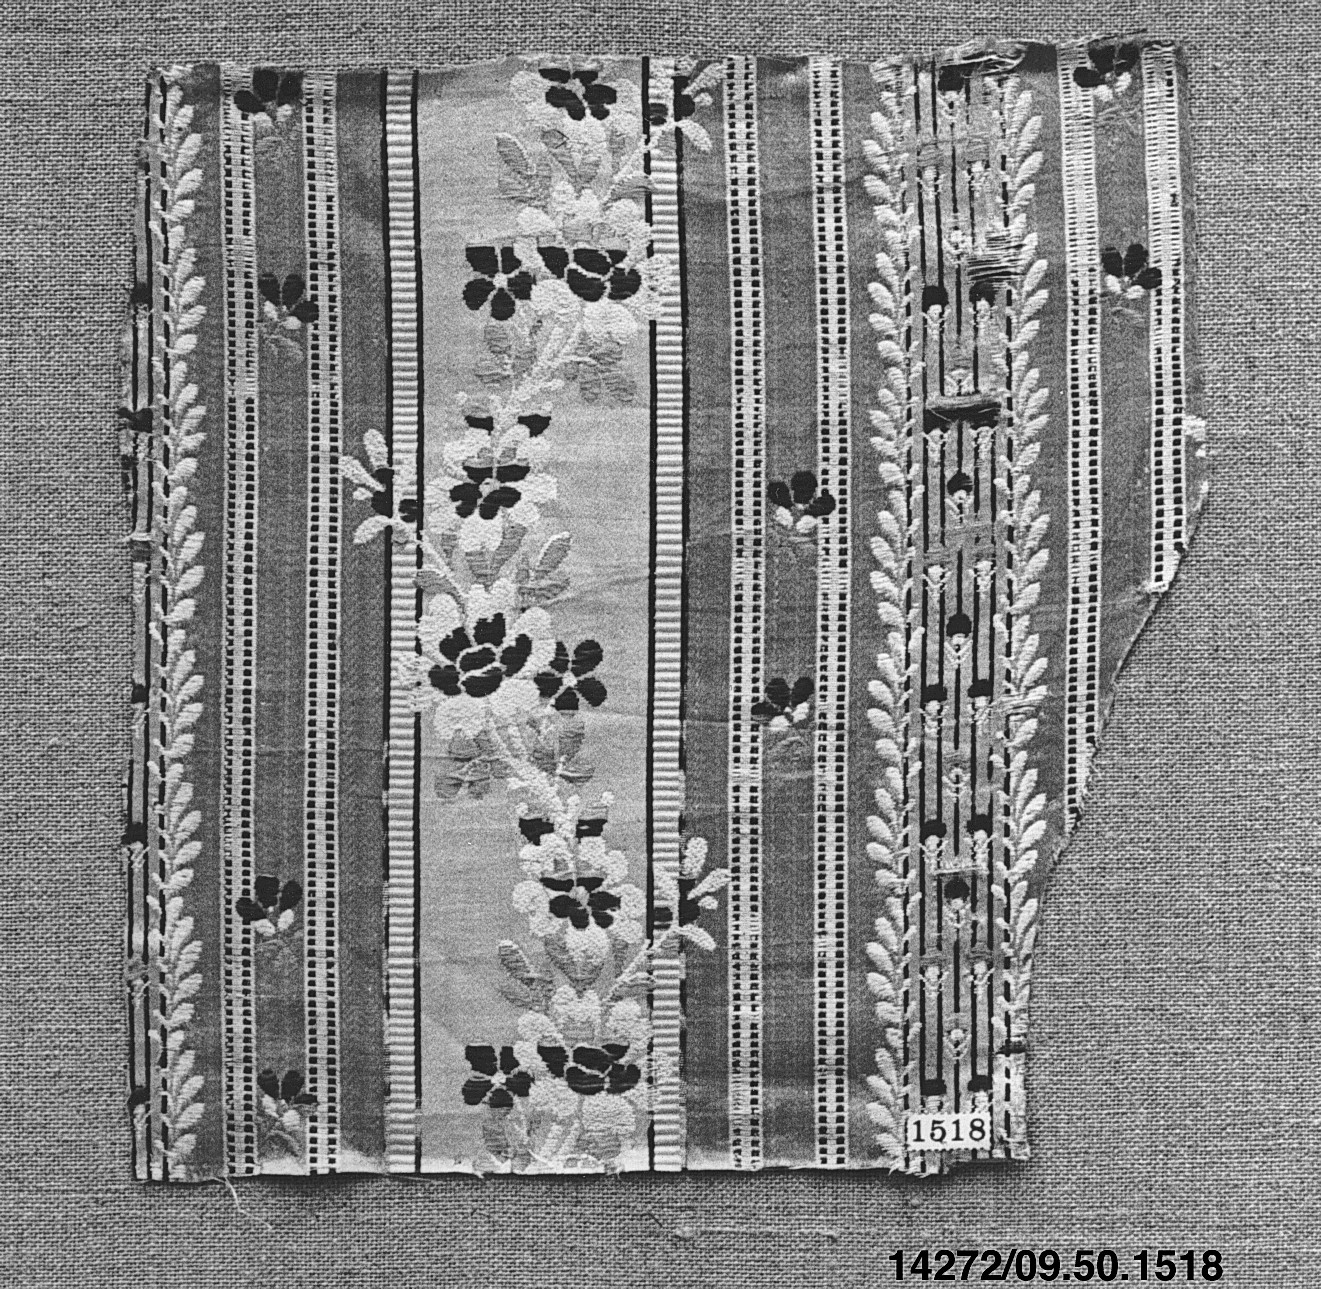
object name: piece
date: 1701-1800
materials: silk